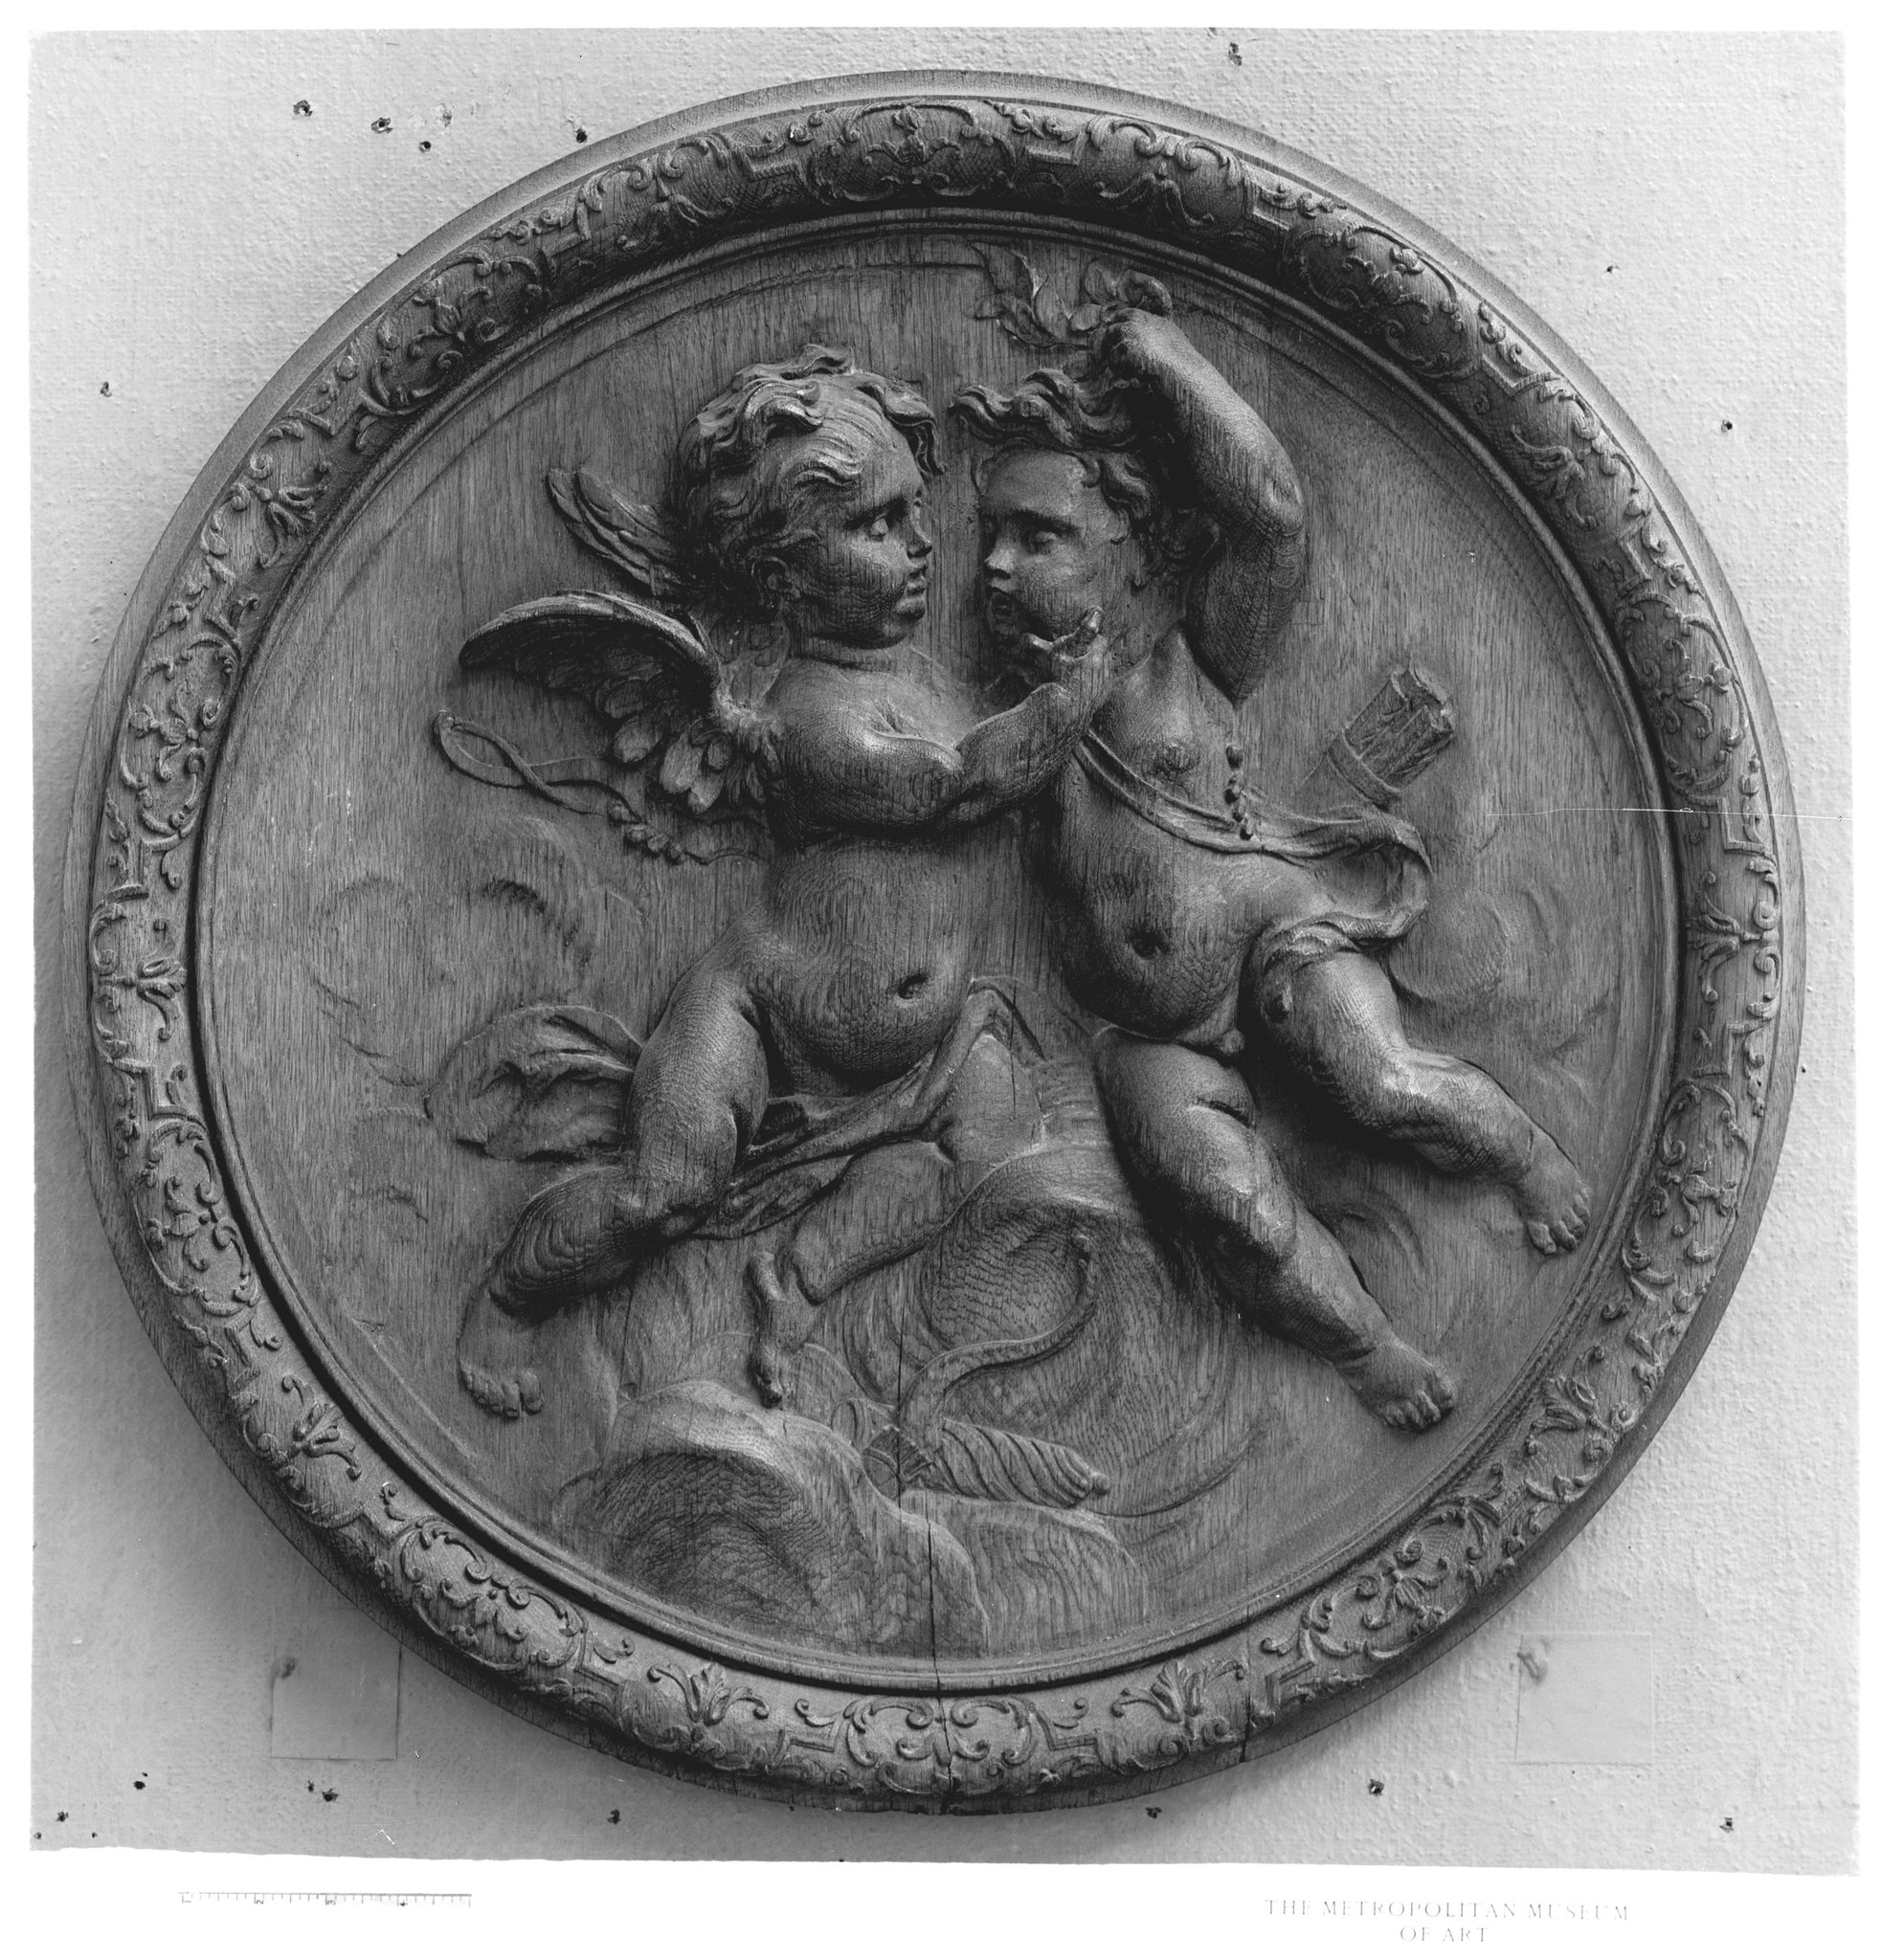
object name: medallion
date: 1667-1733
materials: wood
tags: cupid